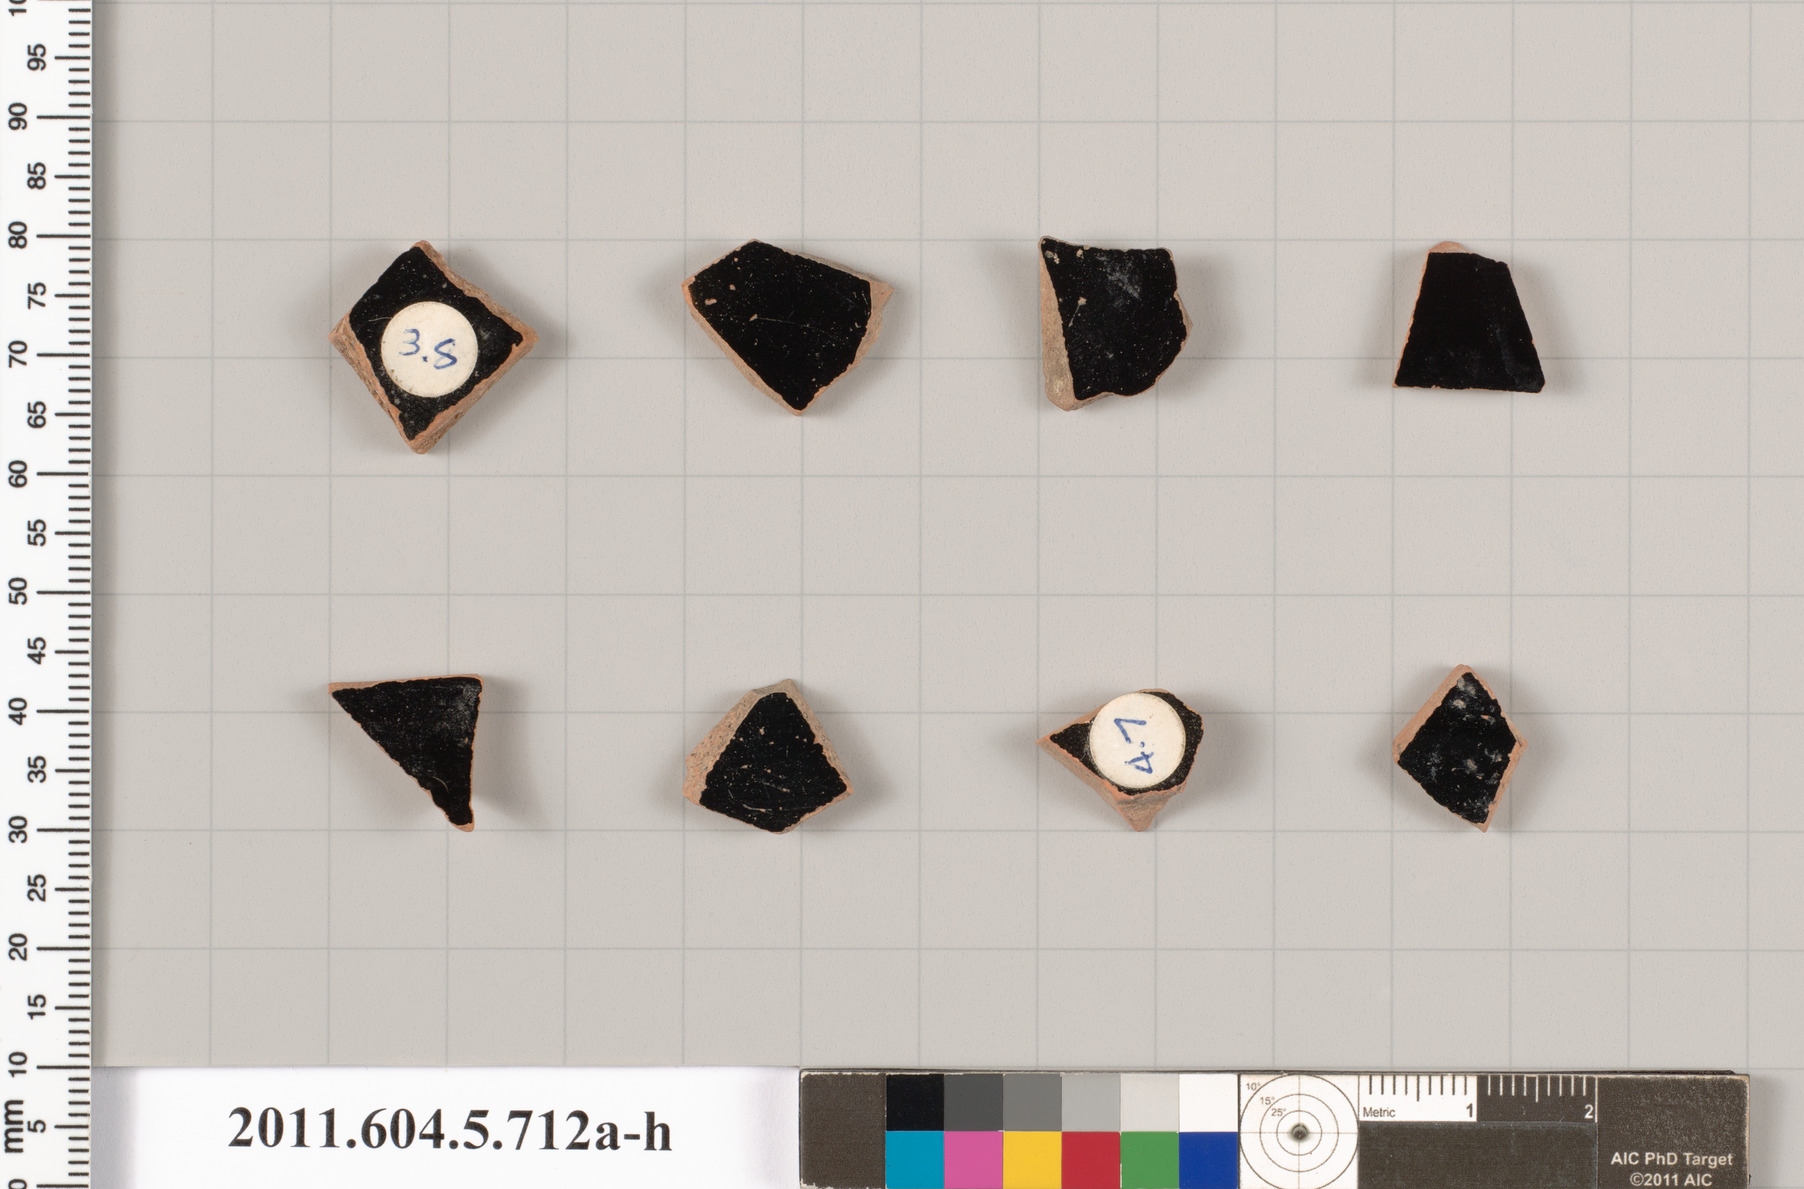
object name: kylix fragment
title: Terracotta fragments of kylikes (drinking cups)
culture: greek, attic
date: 600-401 BCE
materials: terracotta